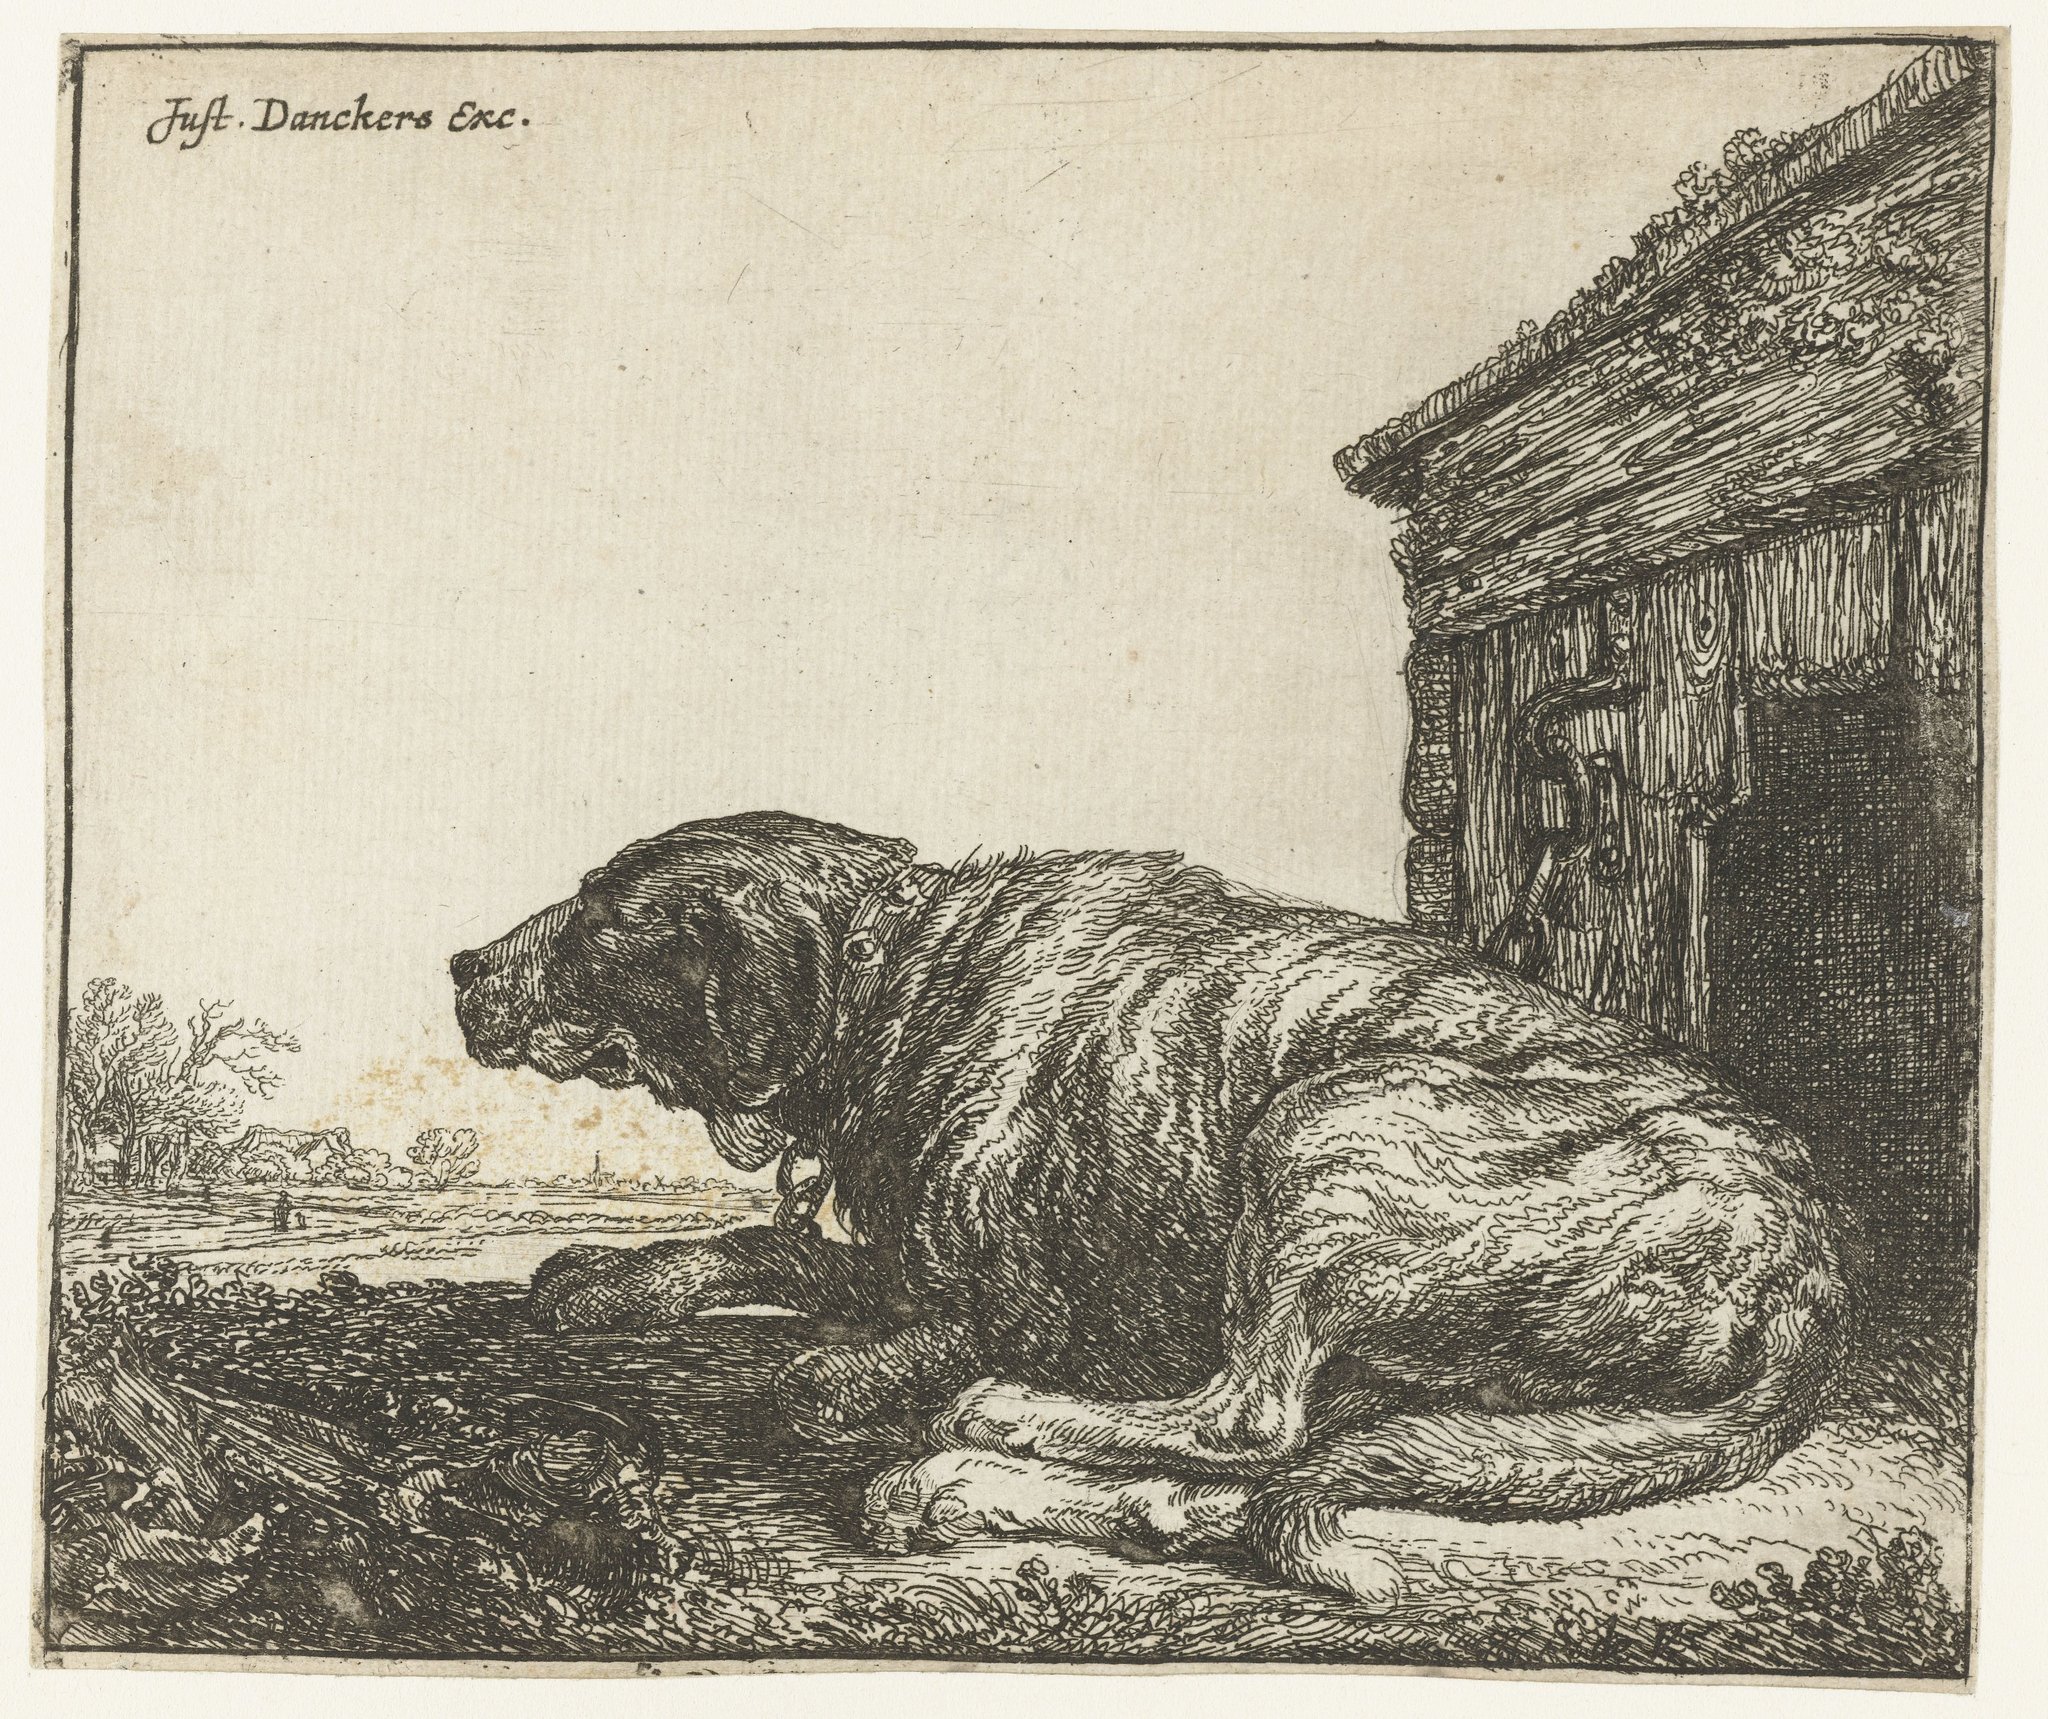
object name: print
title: Waakhond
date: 1610-1653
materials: paper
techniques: drypoint, etching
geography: low countries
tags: watch-dog, dog watching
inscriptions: collector's mark: Lugt 2228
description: Uit een serie van tien prenten. Liggende waakhond aan een ketting, bij en hondenhok.